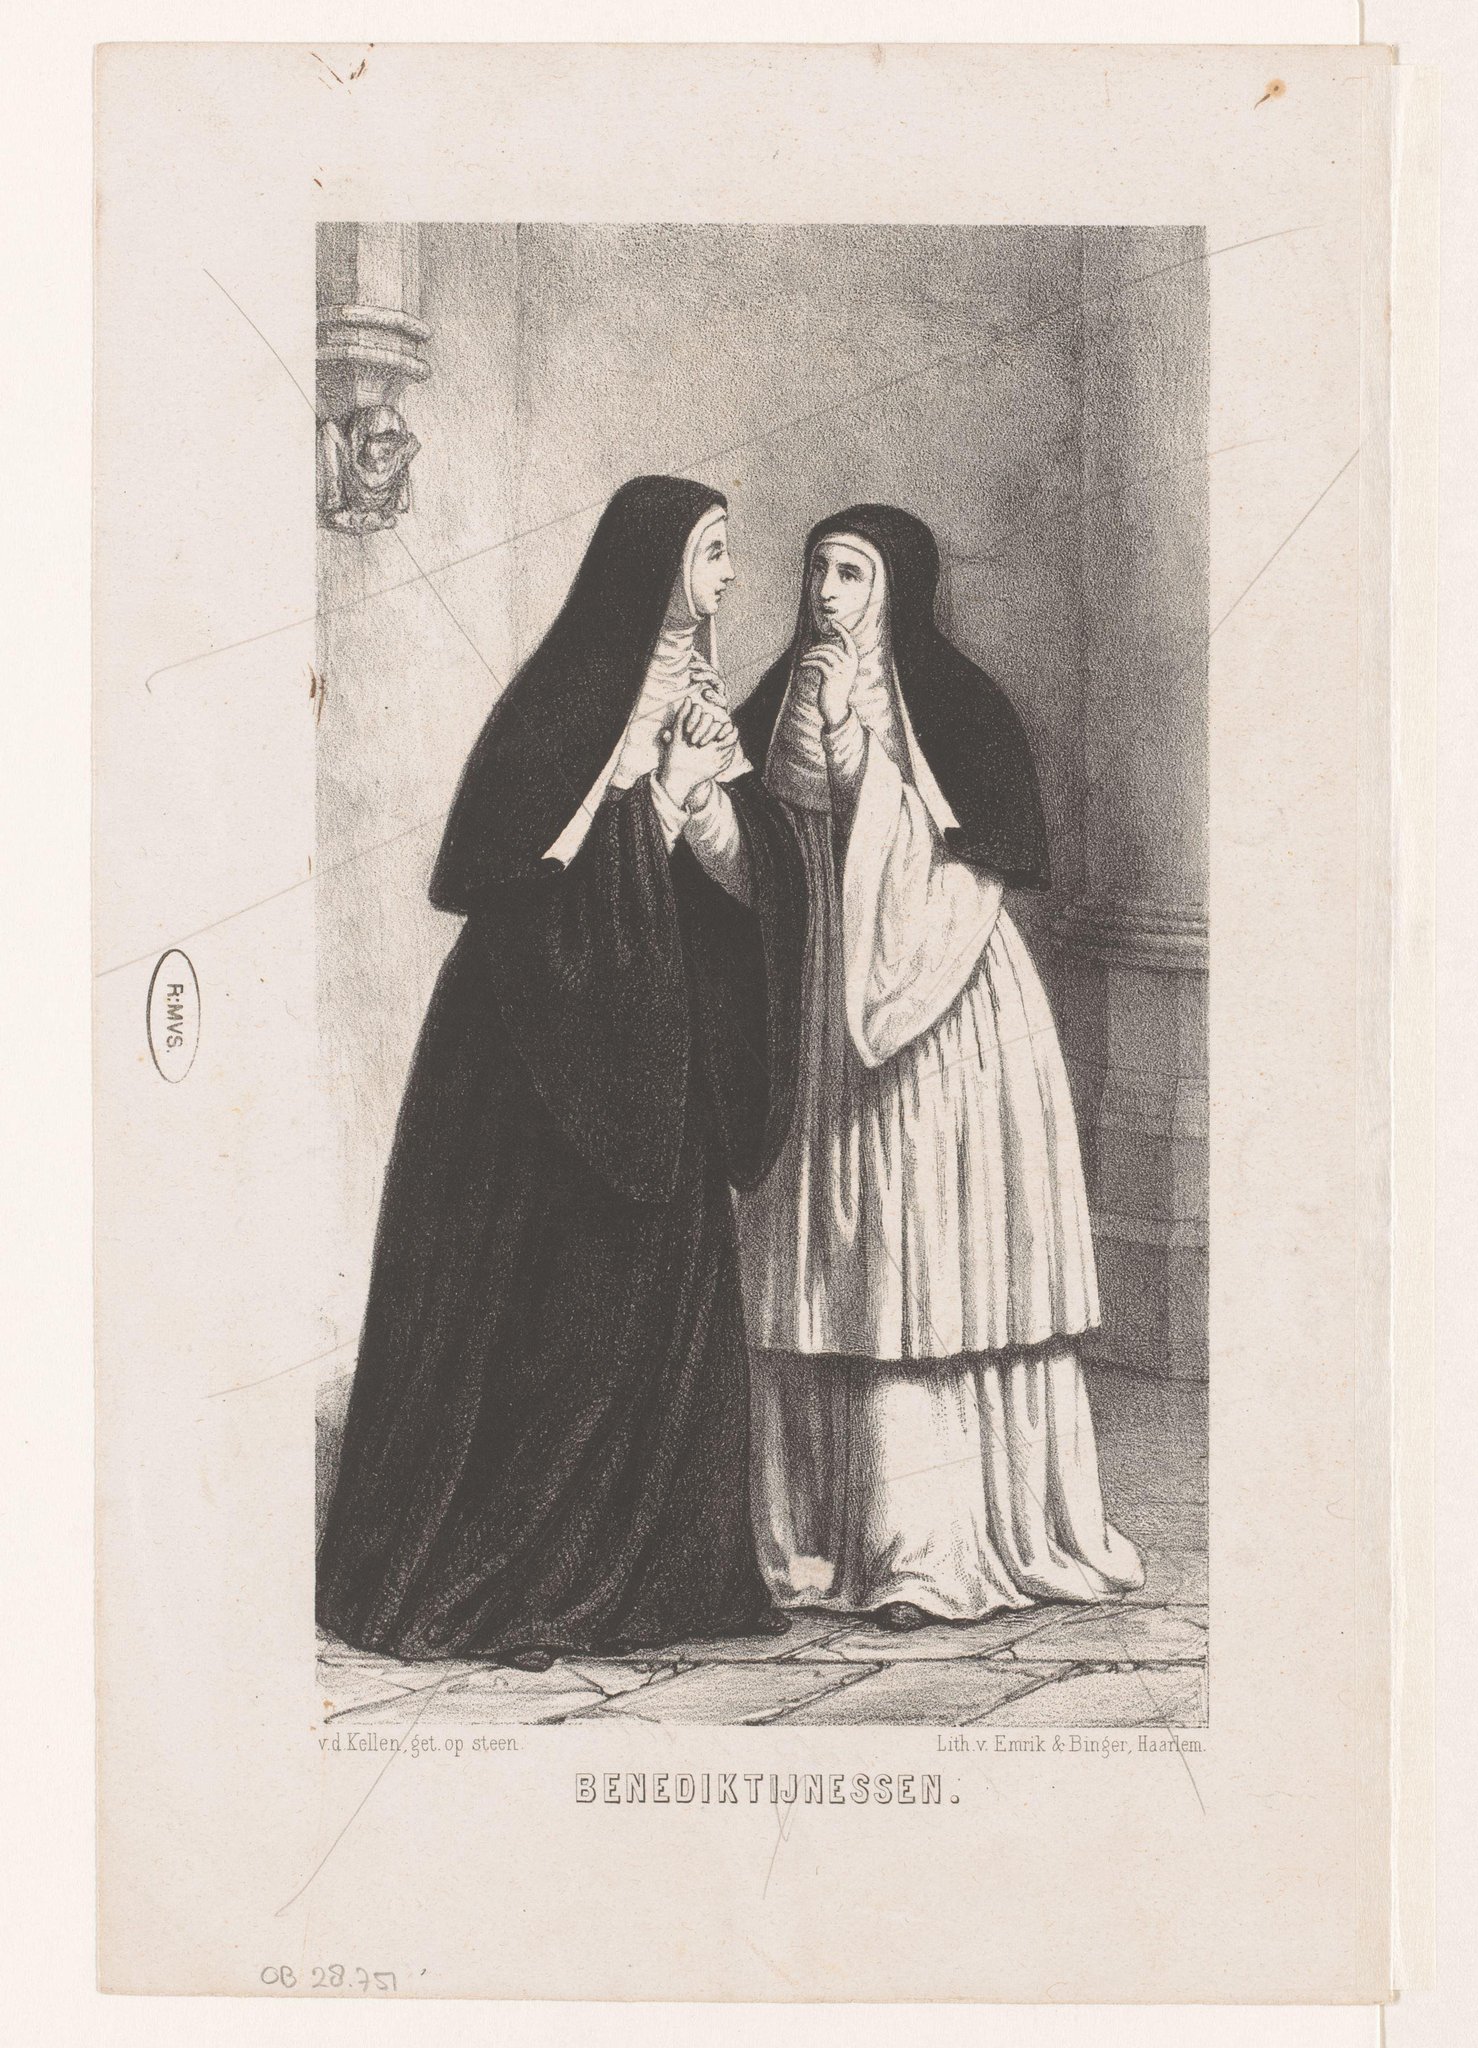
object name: print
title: Benediktijnessen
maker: david van der kellen (1827-1895)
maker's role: draughtsman, print maker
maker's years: 1827-1895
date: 1857-1864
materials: paper, pencil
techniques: lithograph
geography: haarlem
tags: nun(s), monastic orders, monastic life: benedictines, conversation, dialogue; conversation piece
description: De nonnen staan in een interieur en praten met elkaar. Een van hen heeft de handen in elkaar gevouwen.